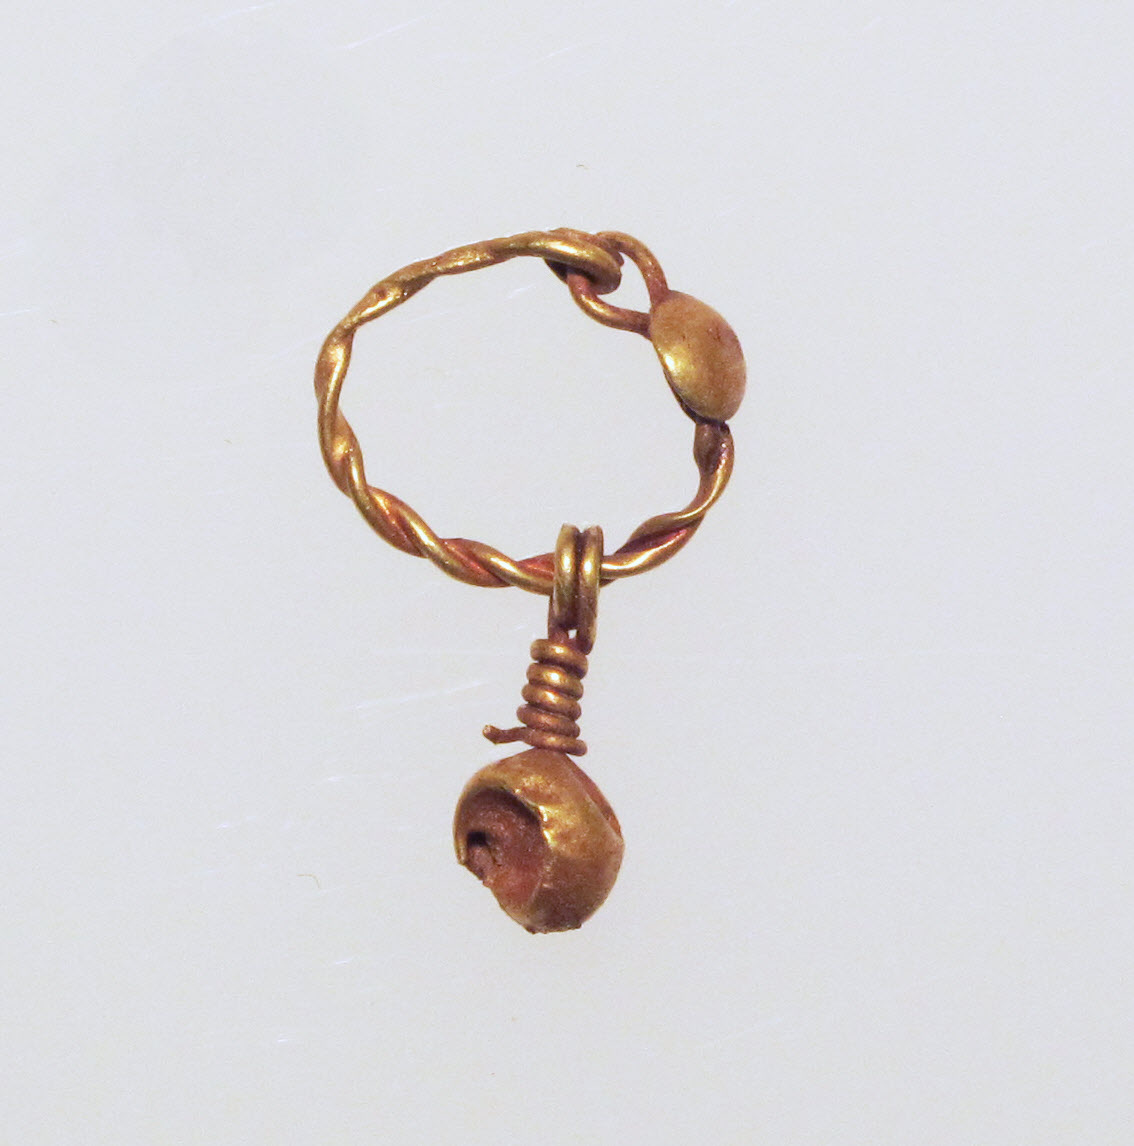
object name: earring with ball pendant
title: Gold earring with disc and pendant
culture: roman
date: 101-200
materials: gold